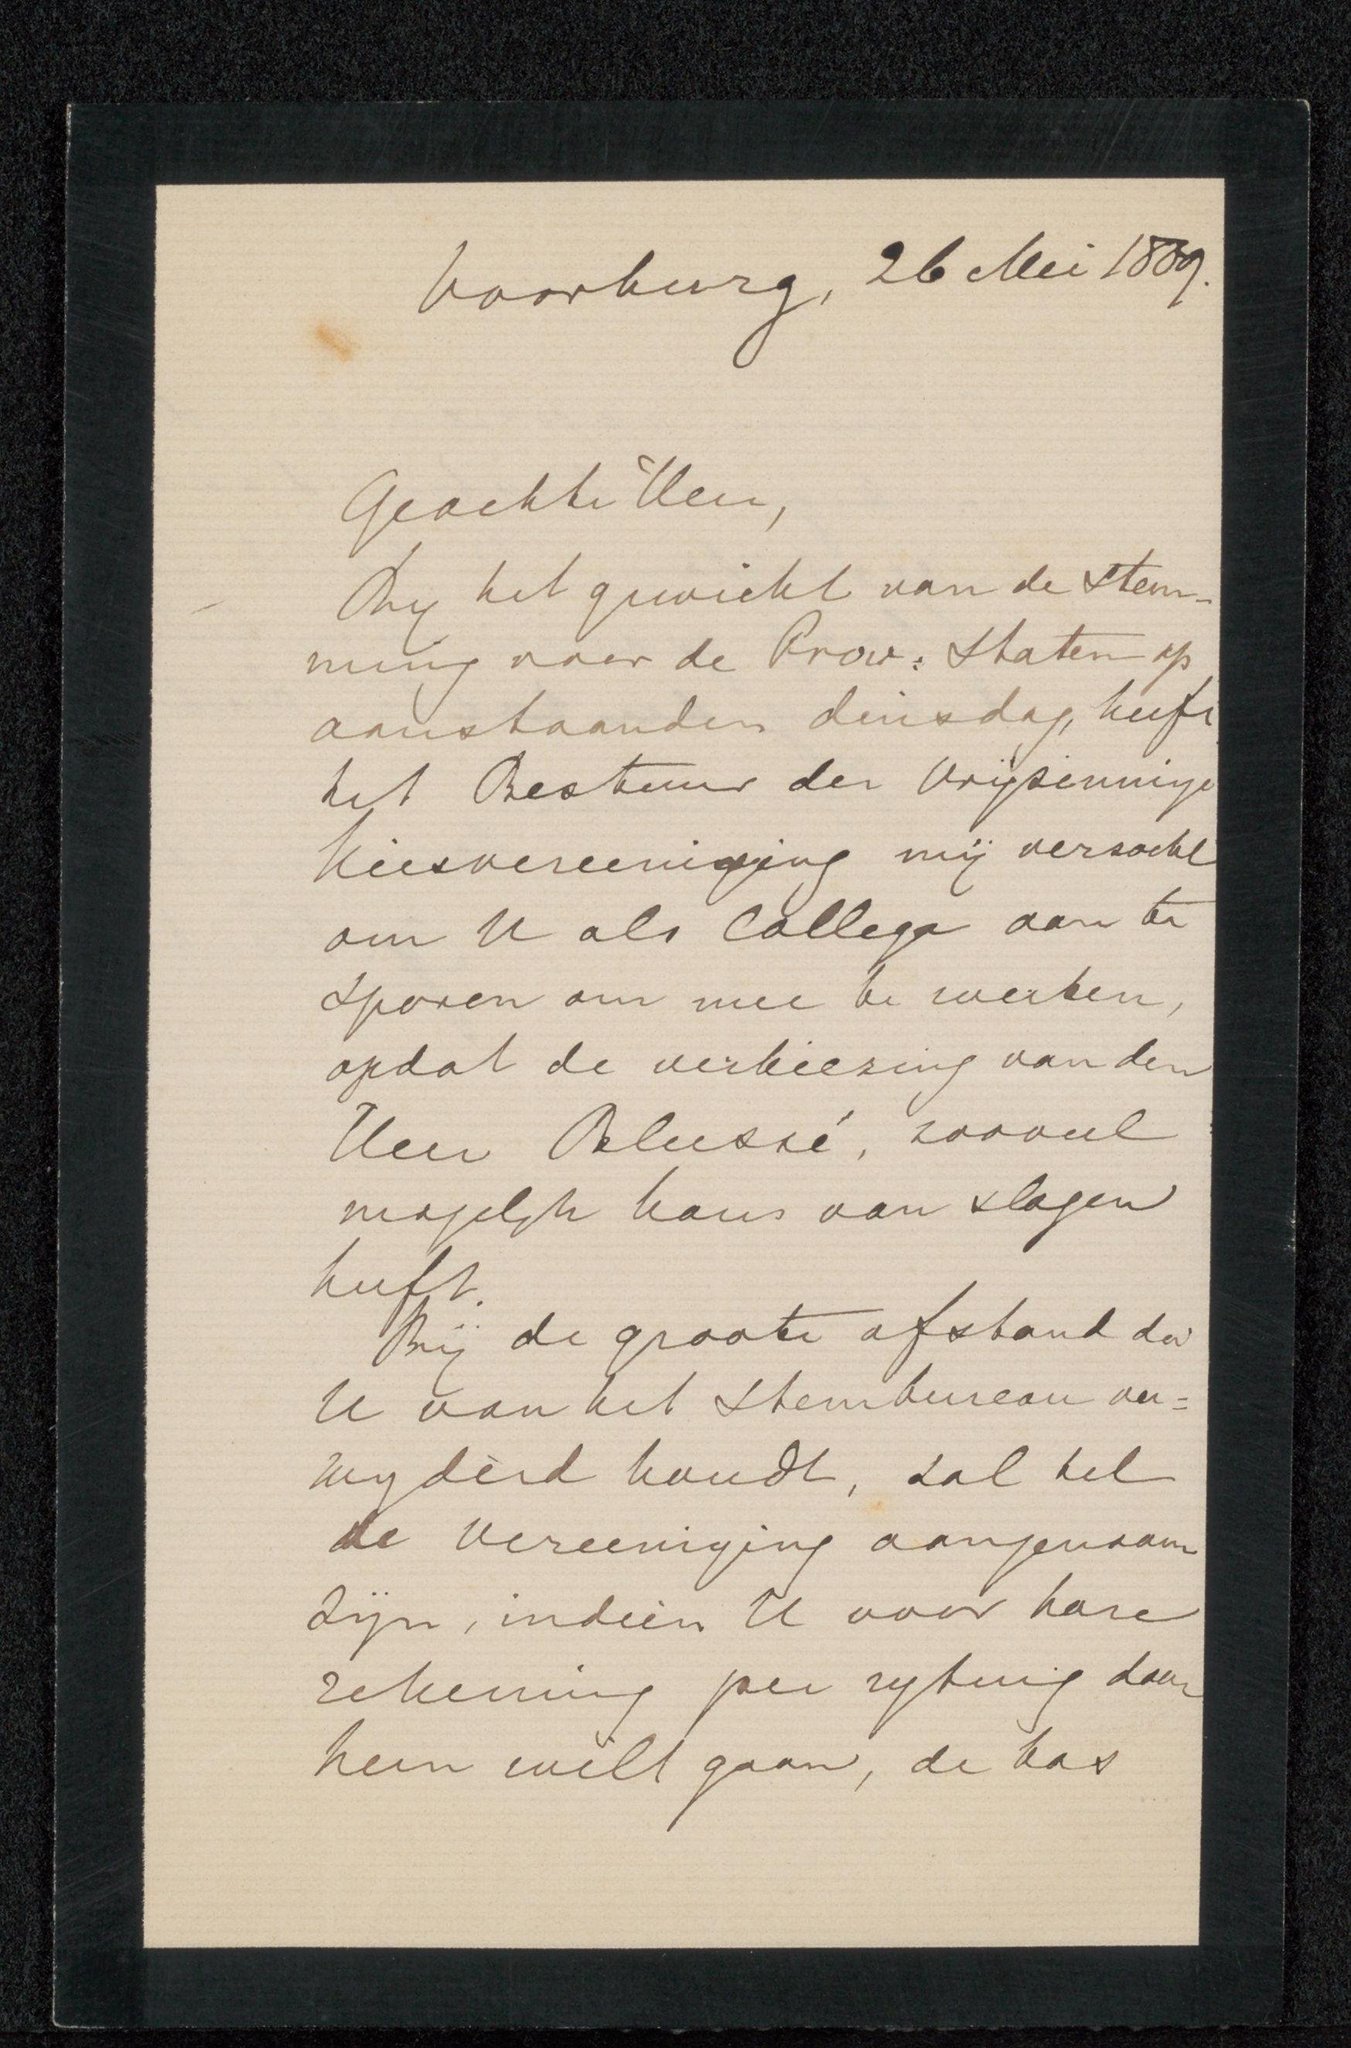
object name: letter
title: Brief aan Philip Zilcken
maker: gerke henkes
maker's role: draughtsman, painter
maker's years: 1844-1927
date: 1889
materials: ink, paper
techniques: pen, writing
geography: voorburg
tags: philip zilcken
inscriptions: collector's mark: ‘RPK’